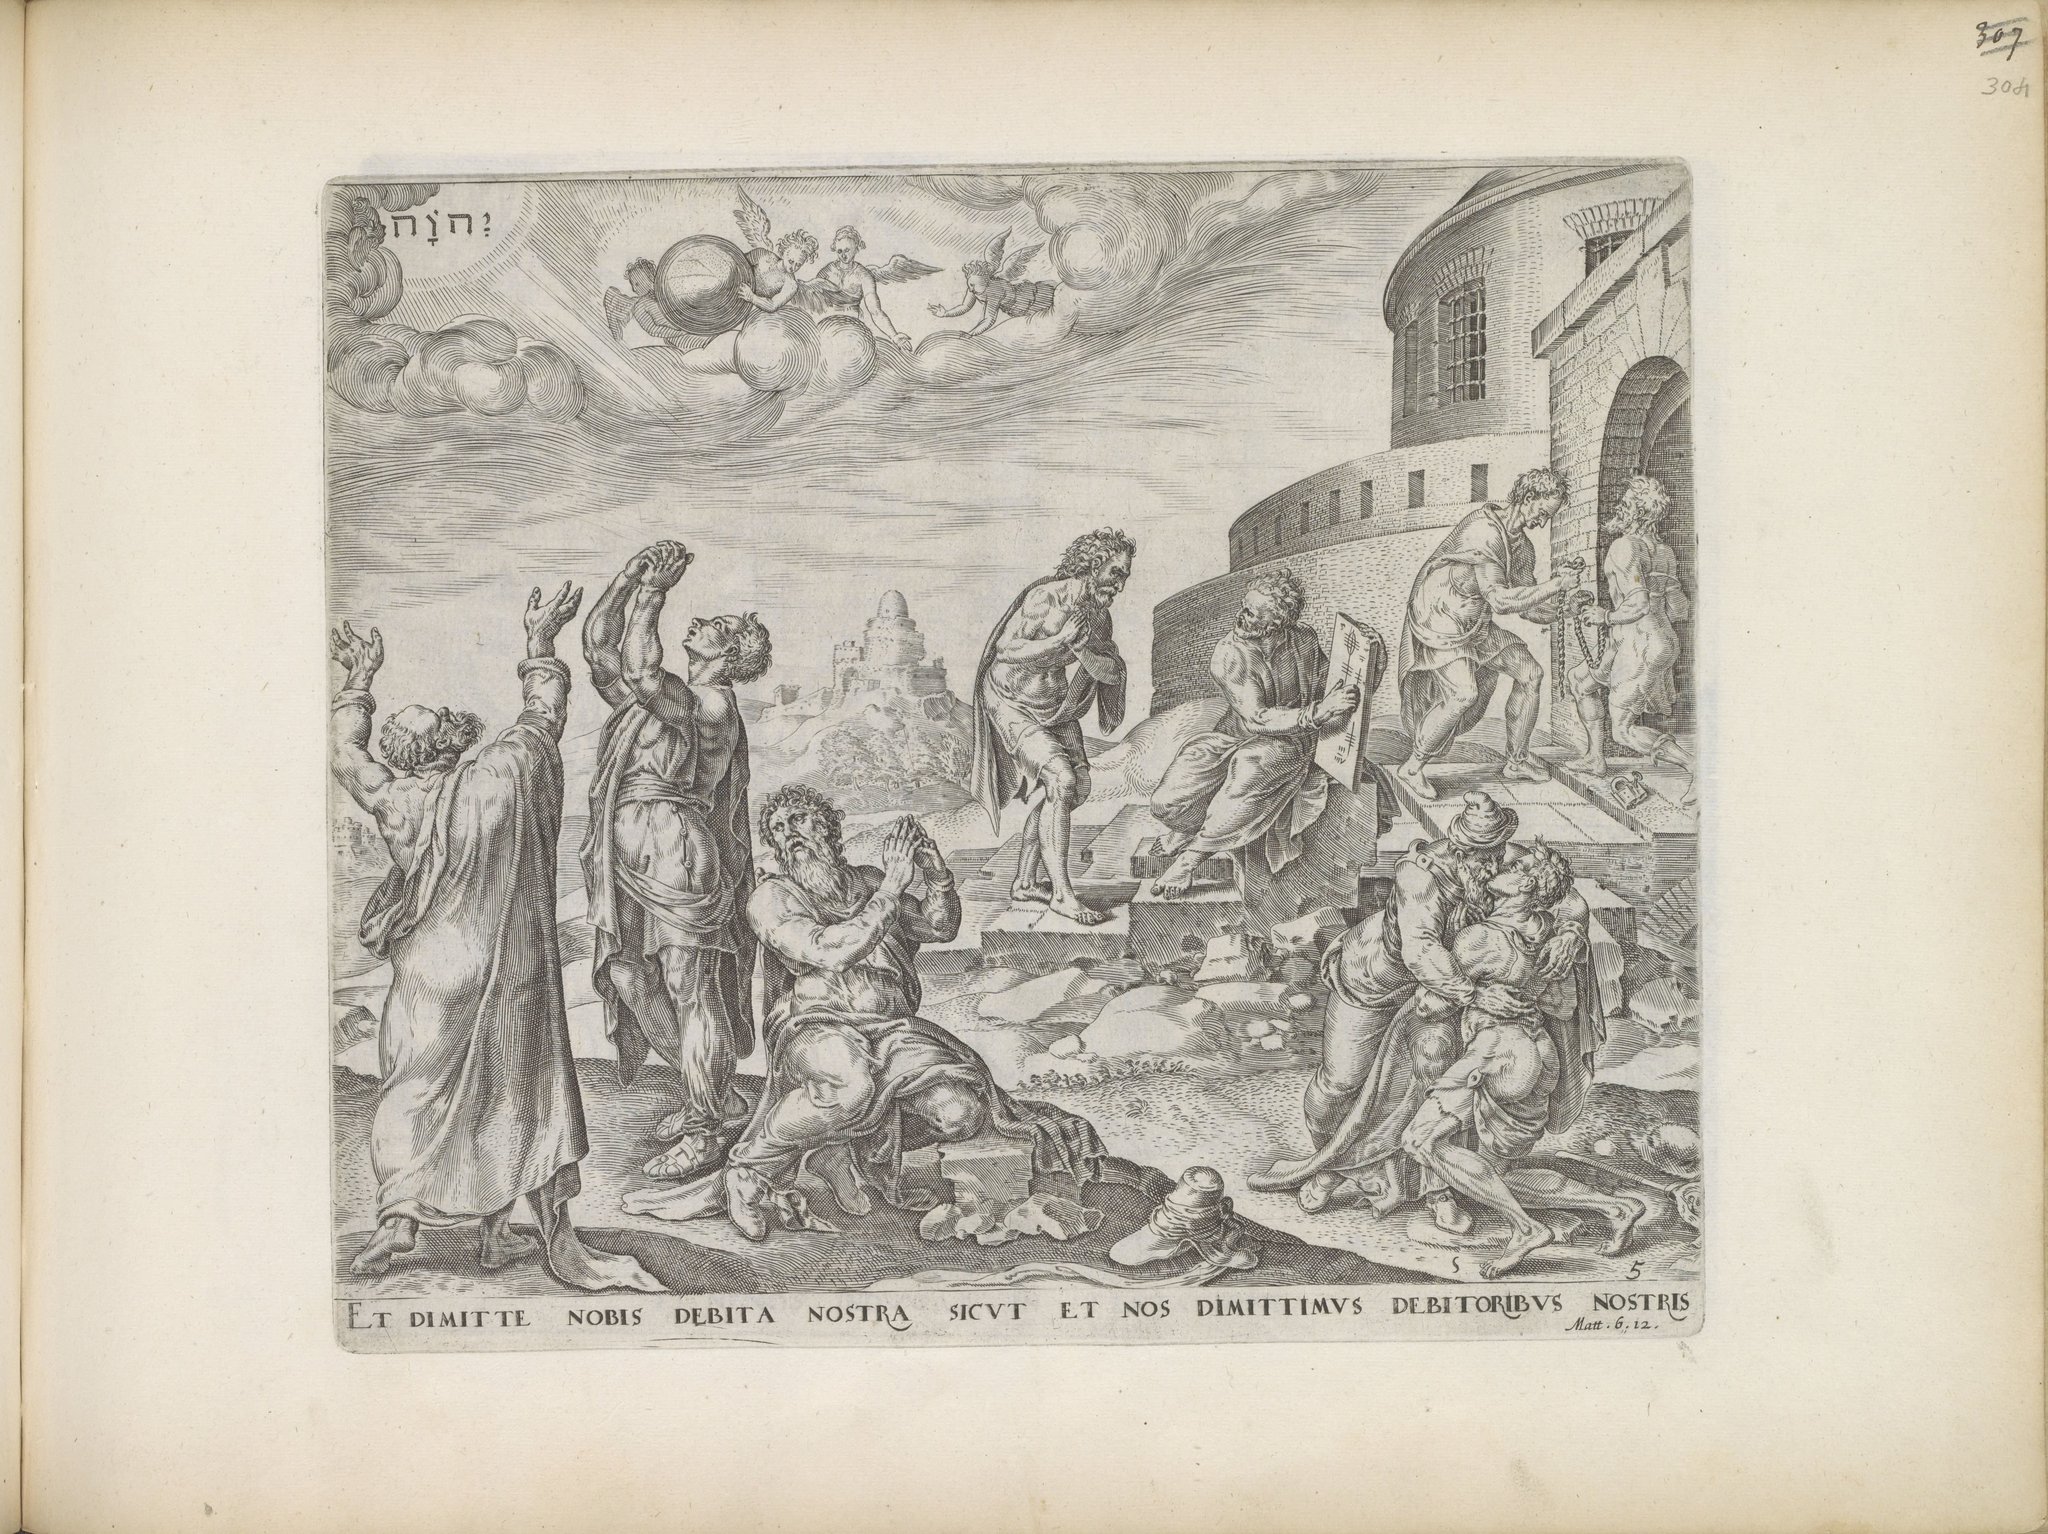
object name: album leaf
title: Theatrum Biblicum Hoc Est Historiae Sacrae Veteris et Novi Testamenti Tabulis Aeneis Expressae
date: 1569-1573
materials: paper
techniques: engraving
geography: amsterdam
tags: tetragram (in roman or hebrew script) ~ symbol of god the father, 'and forgive us our debts, as we also have forgiven our debtors' ~ the lord's prayer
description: Illustratie van een regel van het Onze Vader gebed: Vergeef ons onze schulden, zoals ook wij hebben vergeven wie ons iets schuldig was. Mannen vragen vergiffenis aan God de Vader. Ze bidden richting de hemel, waar het tetragram als symbool van God de Vader verschijnt. Ze vergeven tevens elkaar. Een man wordt uit de gevangenis bevrijd. Rechts op de voorgrond omarmt de vader de verloren zoon. Onder de voorstelling dit gedeelte van het Onze Vader in het Latijn en een verwijzing naar de Bijbeltekst in Mat. 6:12. Deze prent maakt deel uit van een album.